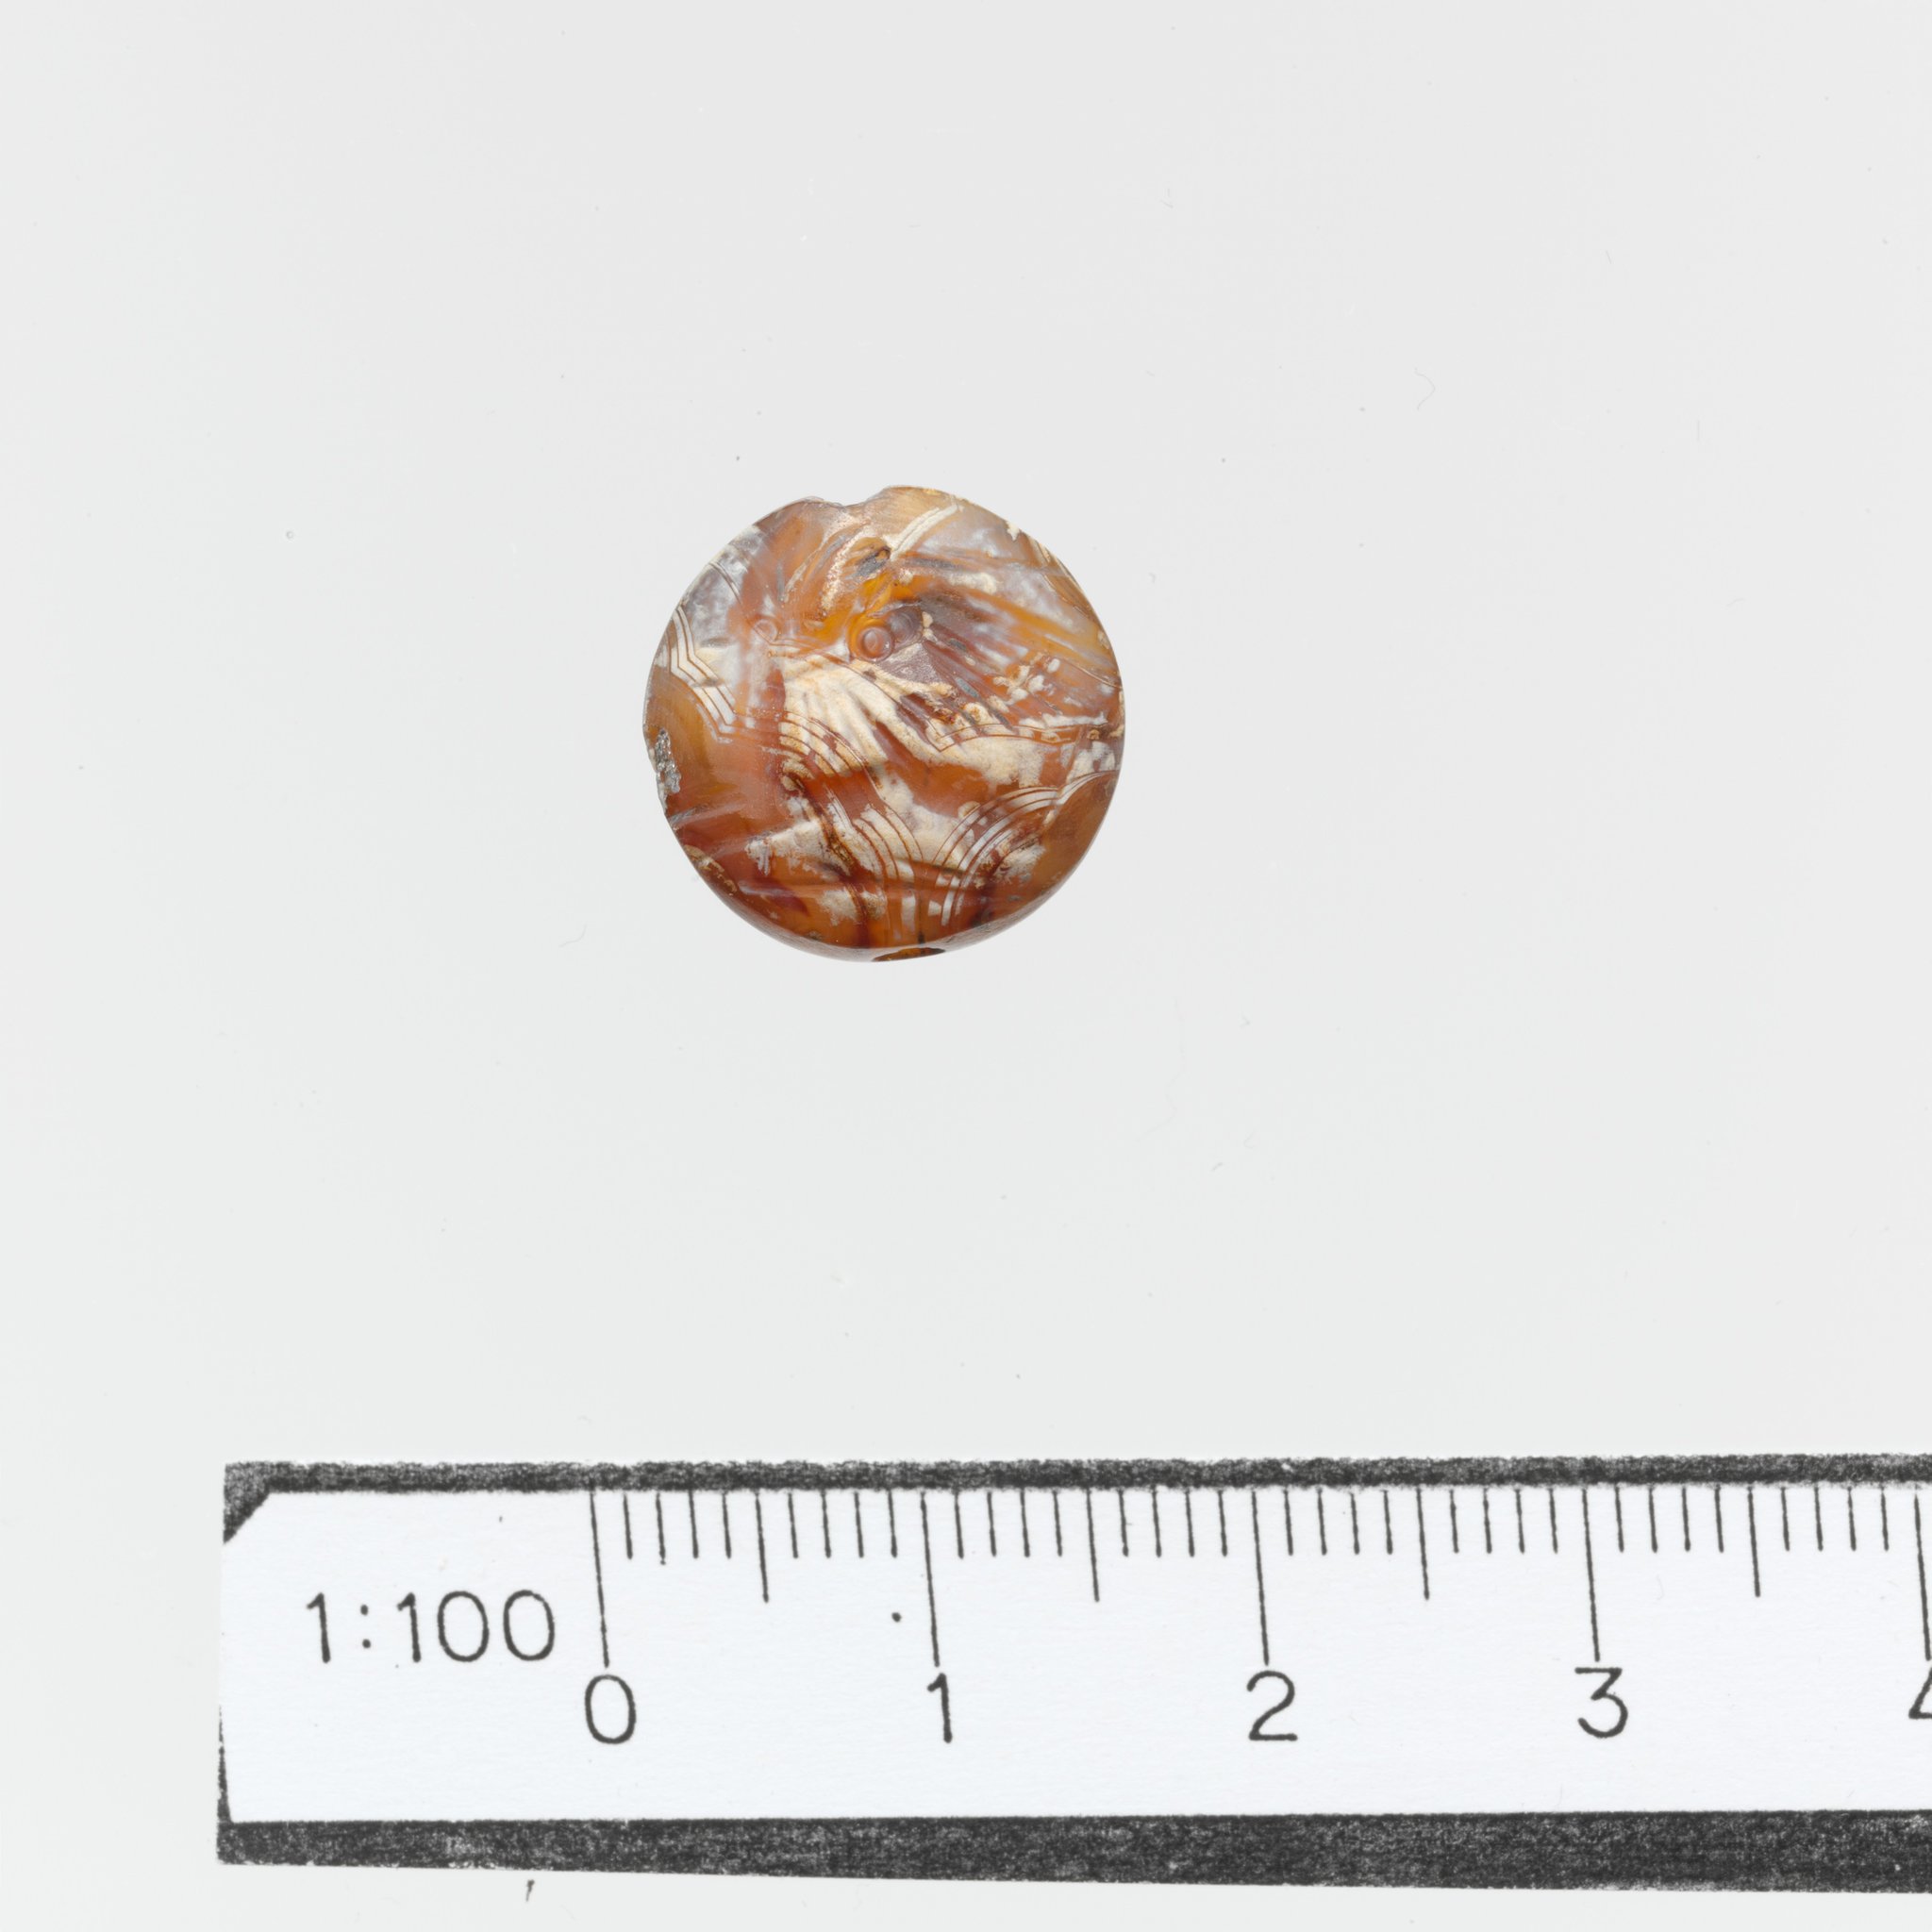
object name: seal, lentoid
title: Sardonyx lentoid seal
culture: minoan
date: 1450-1400 BCE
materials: gemstone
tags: griffins